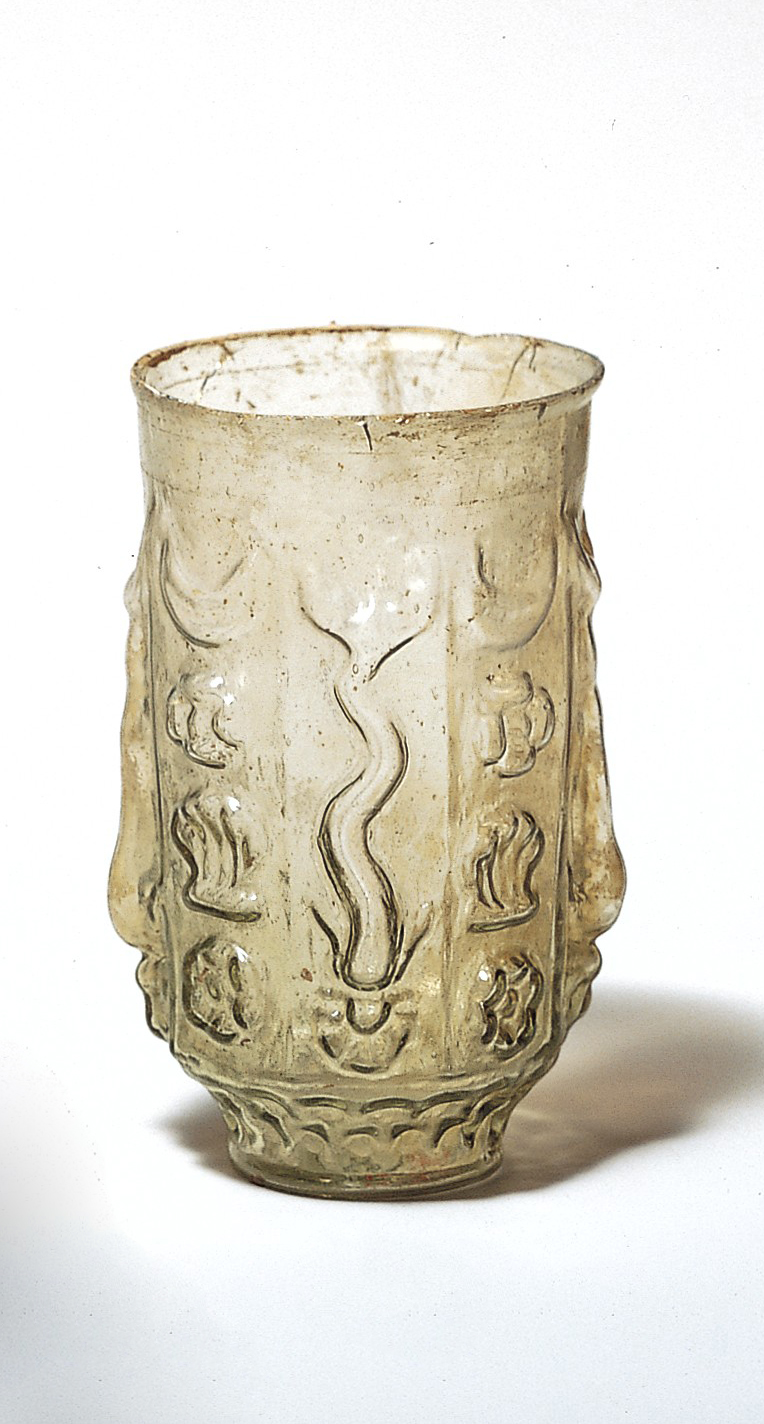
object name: beaker with dolphin, rosette, shell and crescent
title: Glass beaker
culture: roman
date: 51-100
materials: glass